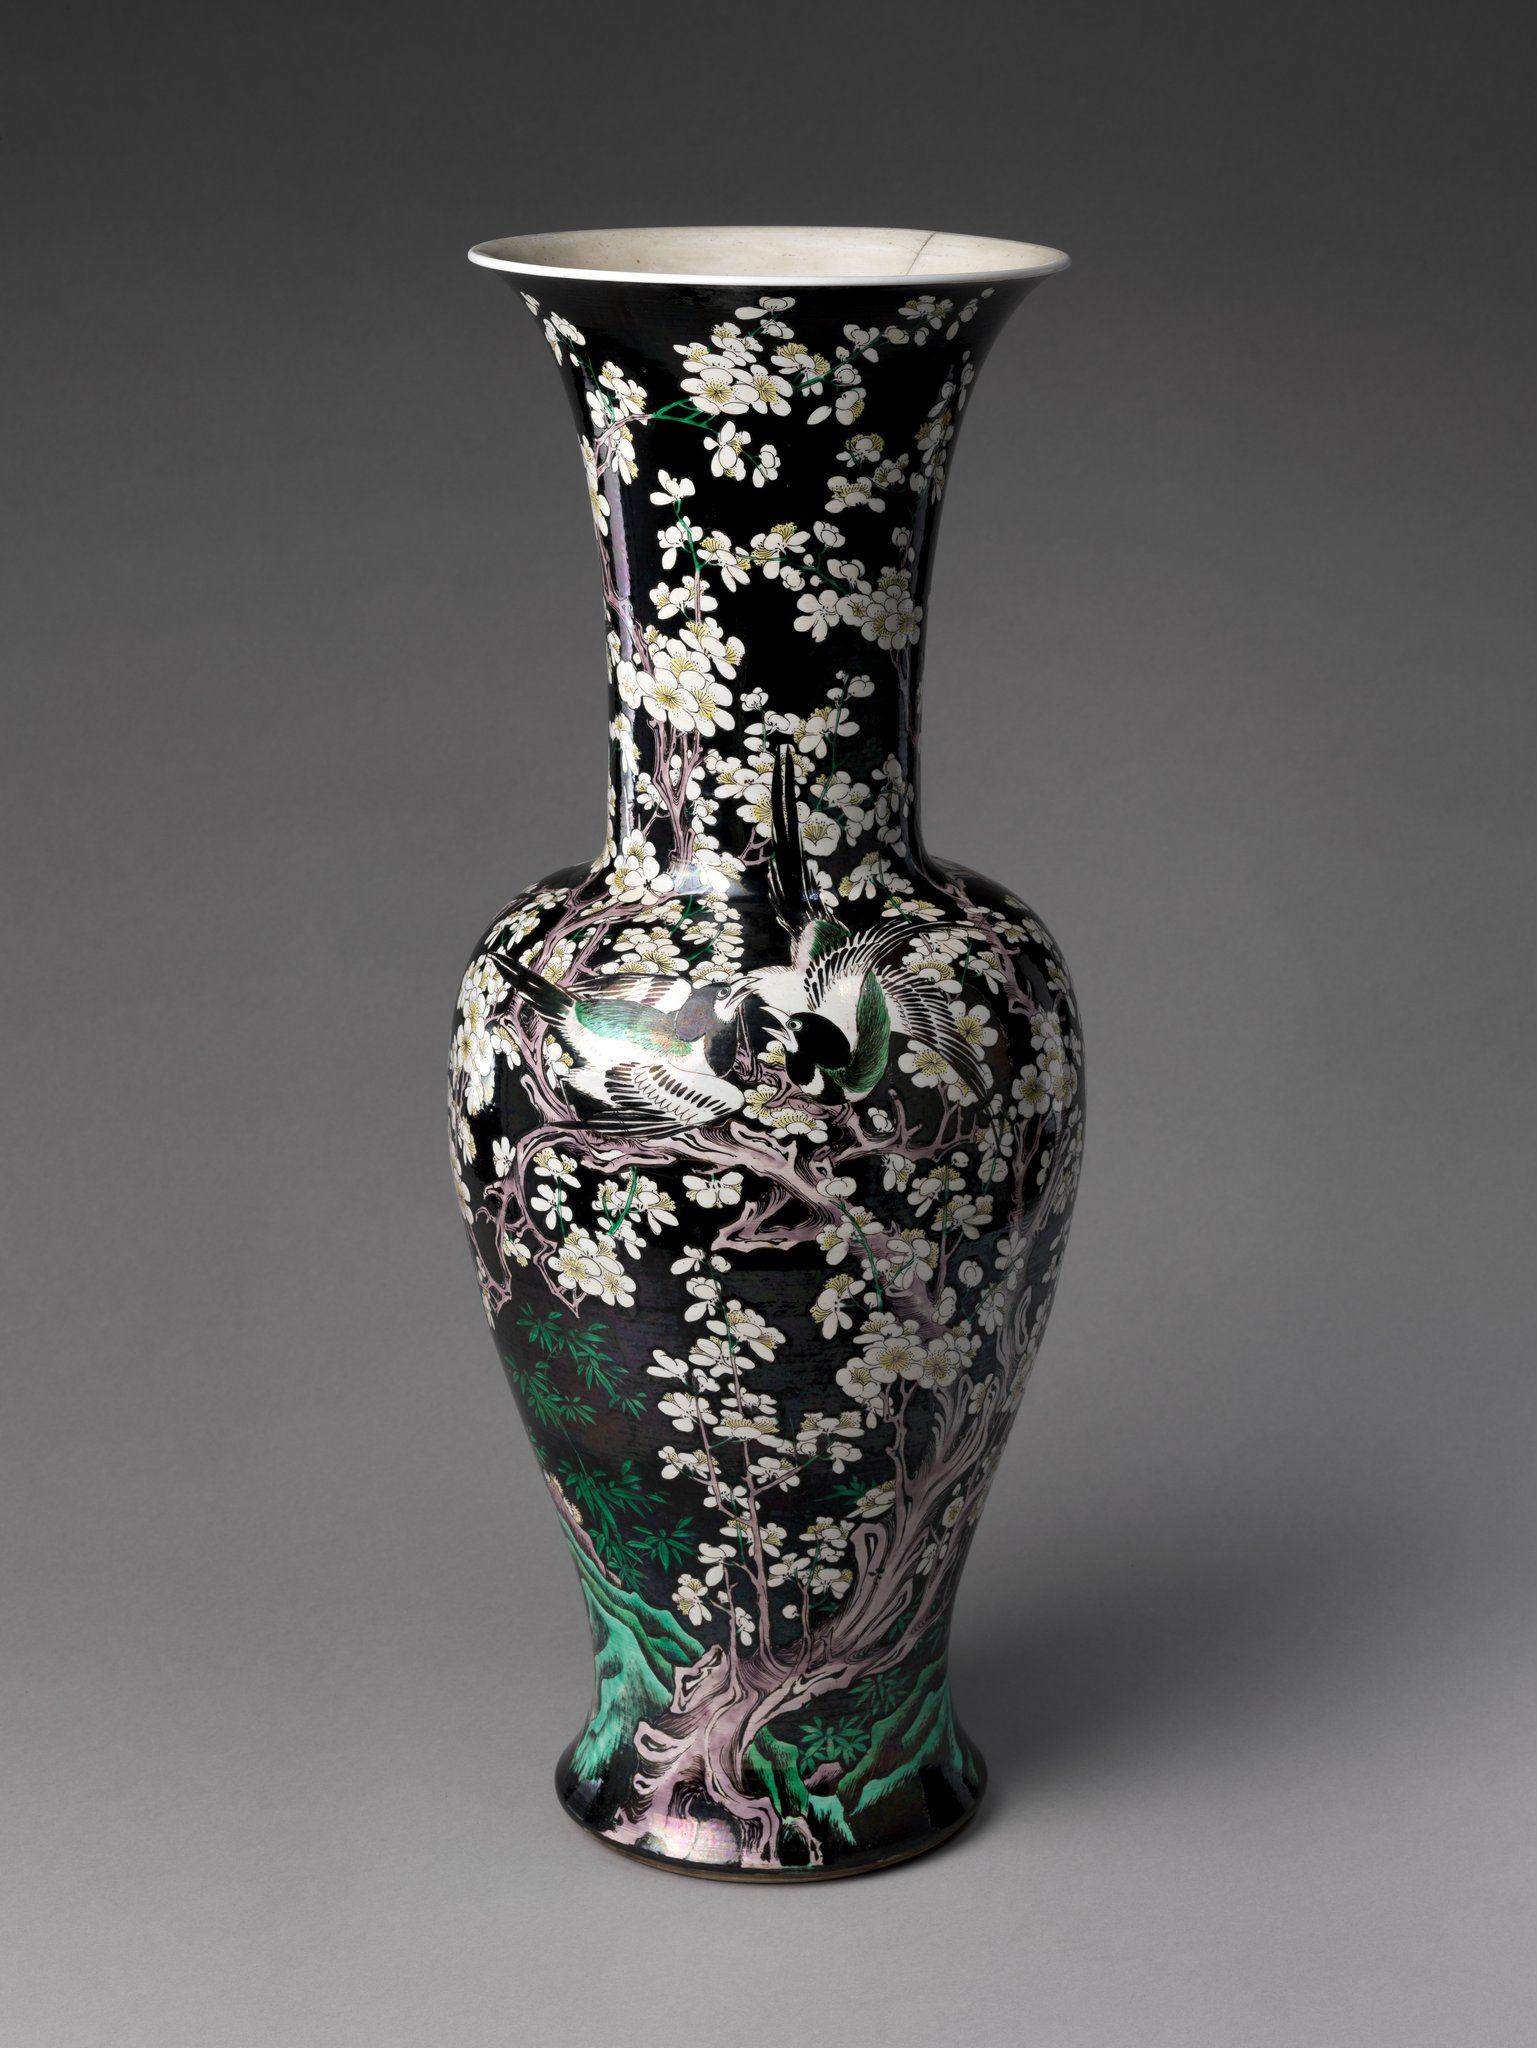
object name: vase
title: Vase with Plum Blossoms and Birds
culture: chinese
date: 1867-1900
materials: biscuit, enamel, porcelain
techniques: painting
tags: birds,flowers